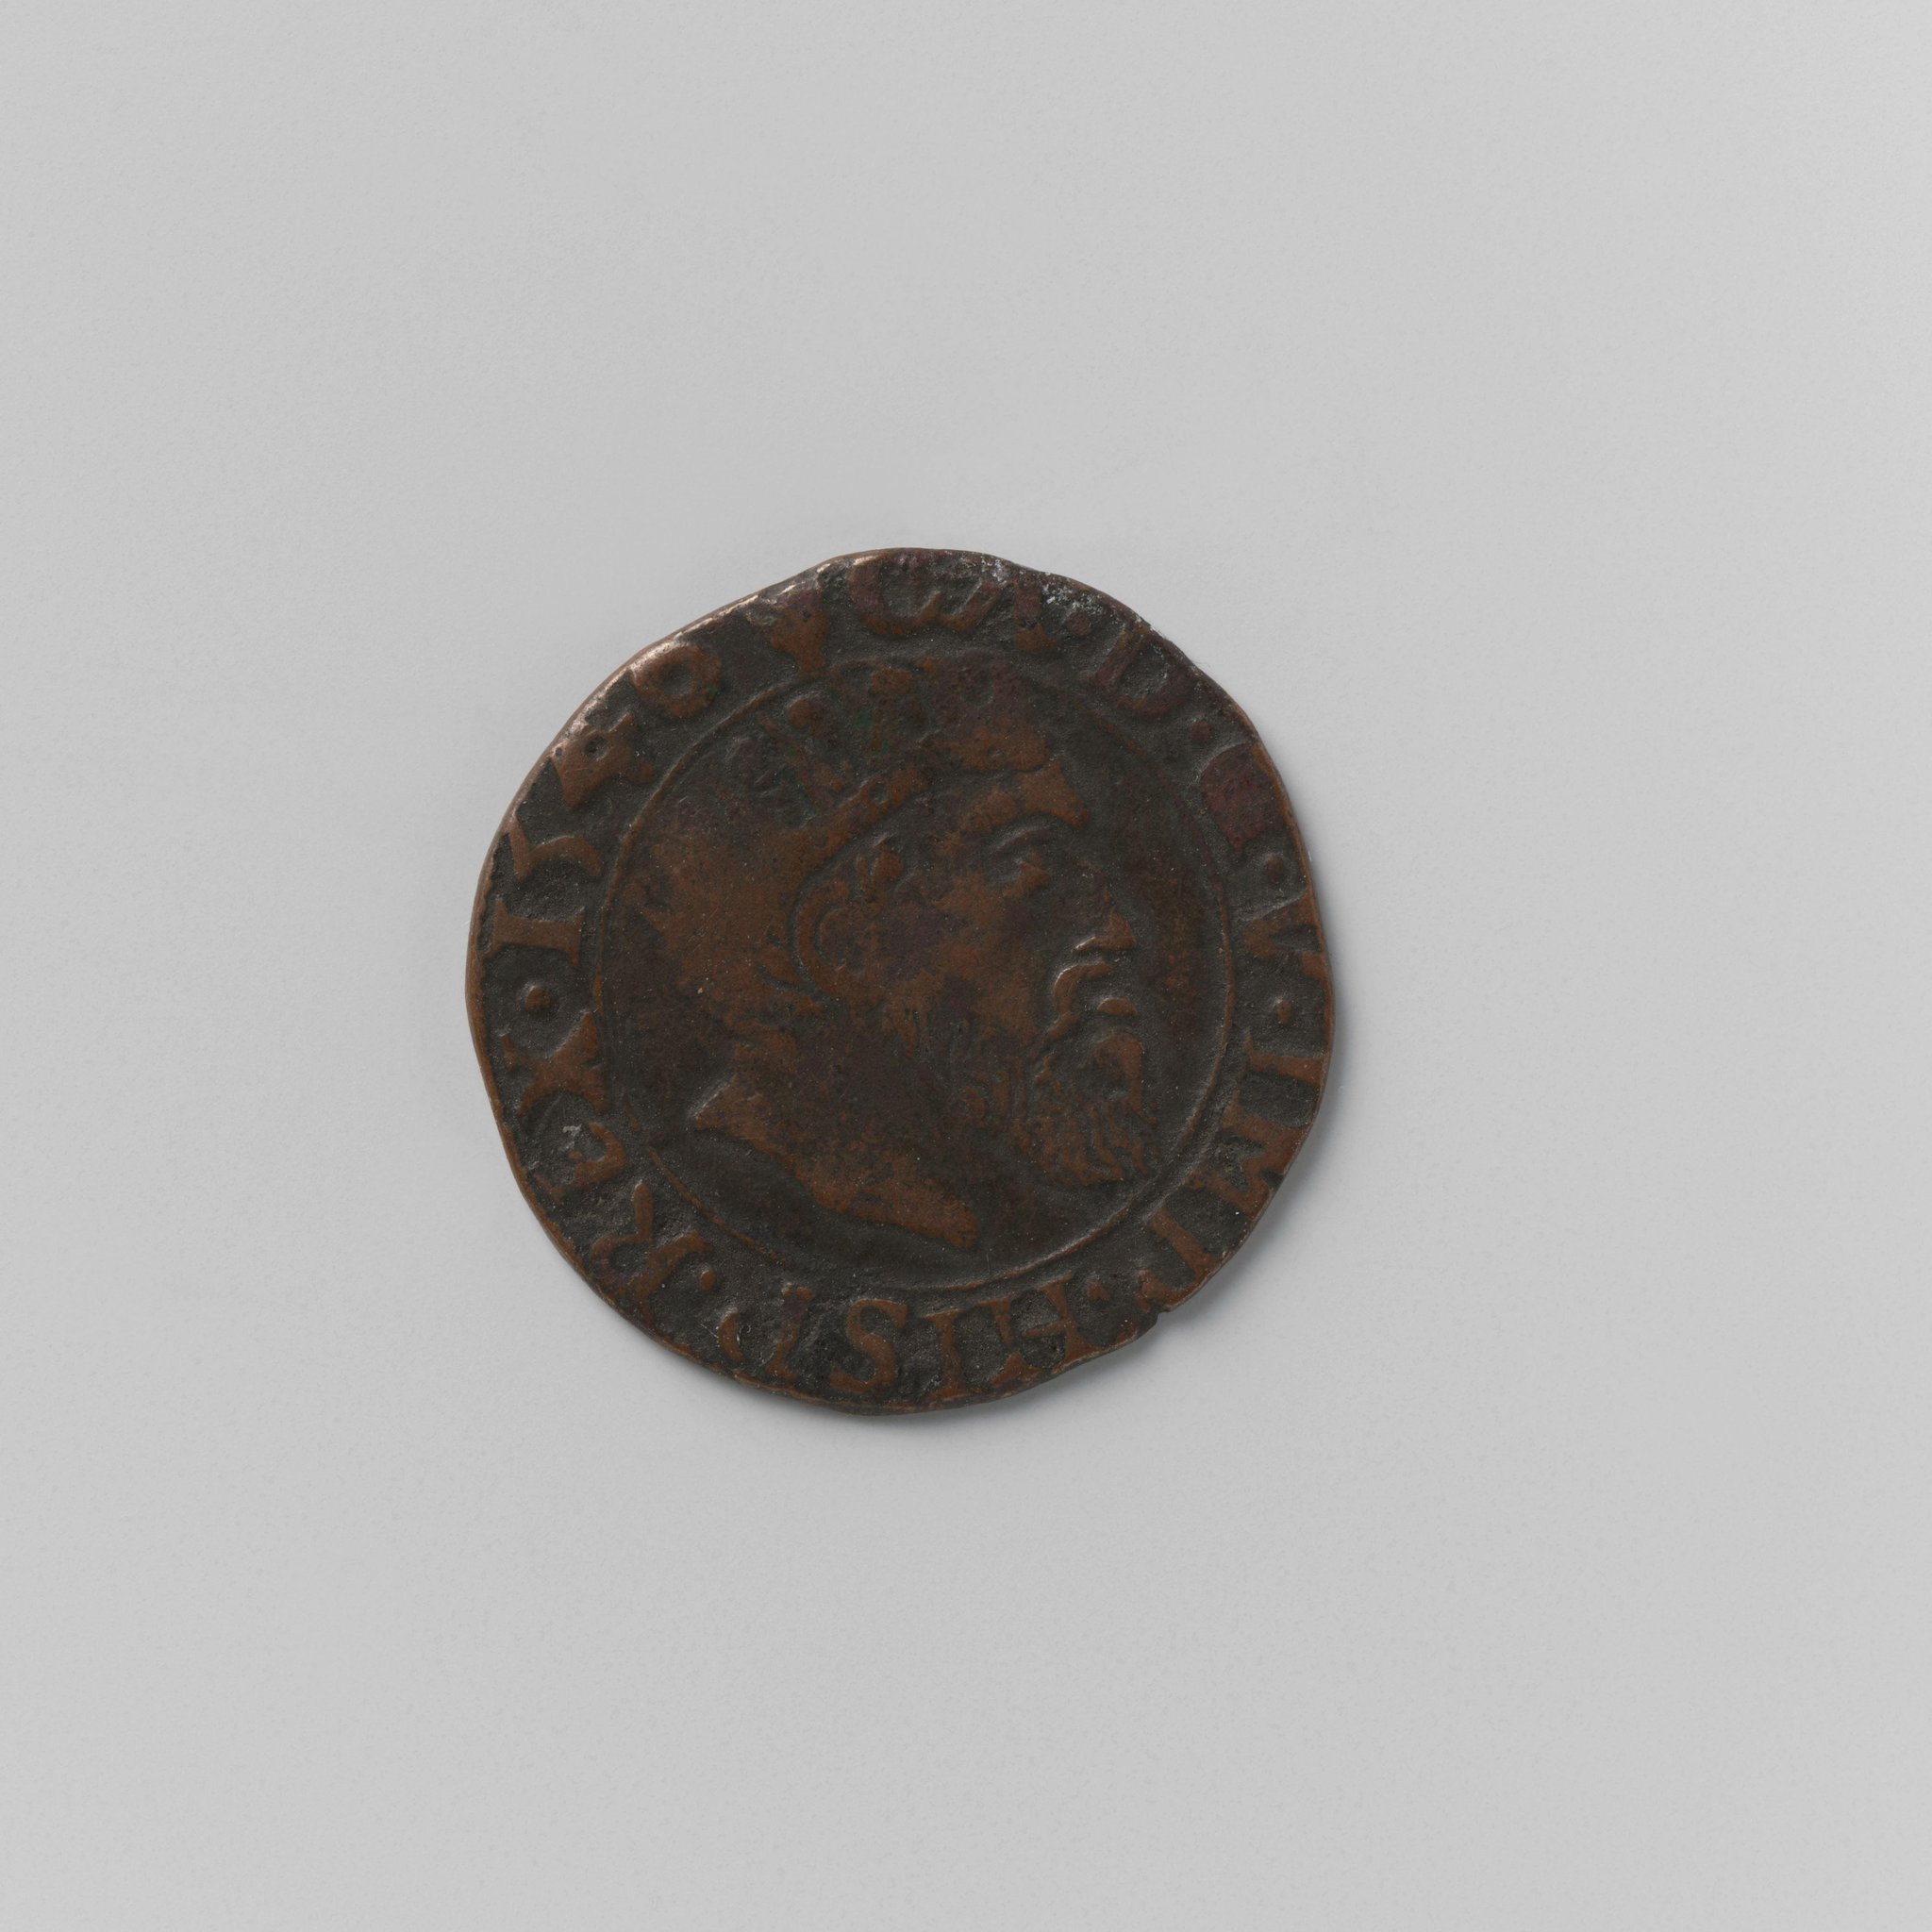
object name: coin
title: Korte uit Brabant van Karel V, 1546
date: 1546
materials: copper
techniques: striking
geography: antwerp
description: Koperen munt. Voorzijde: hoofd van Karel V met stralenkrans naar rechts. Jaartal in omschrift.Keerzijde: in een randversiering klimmende leeuw naar links. Geen omschrift.